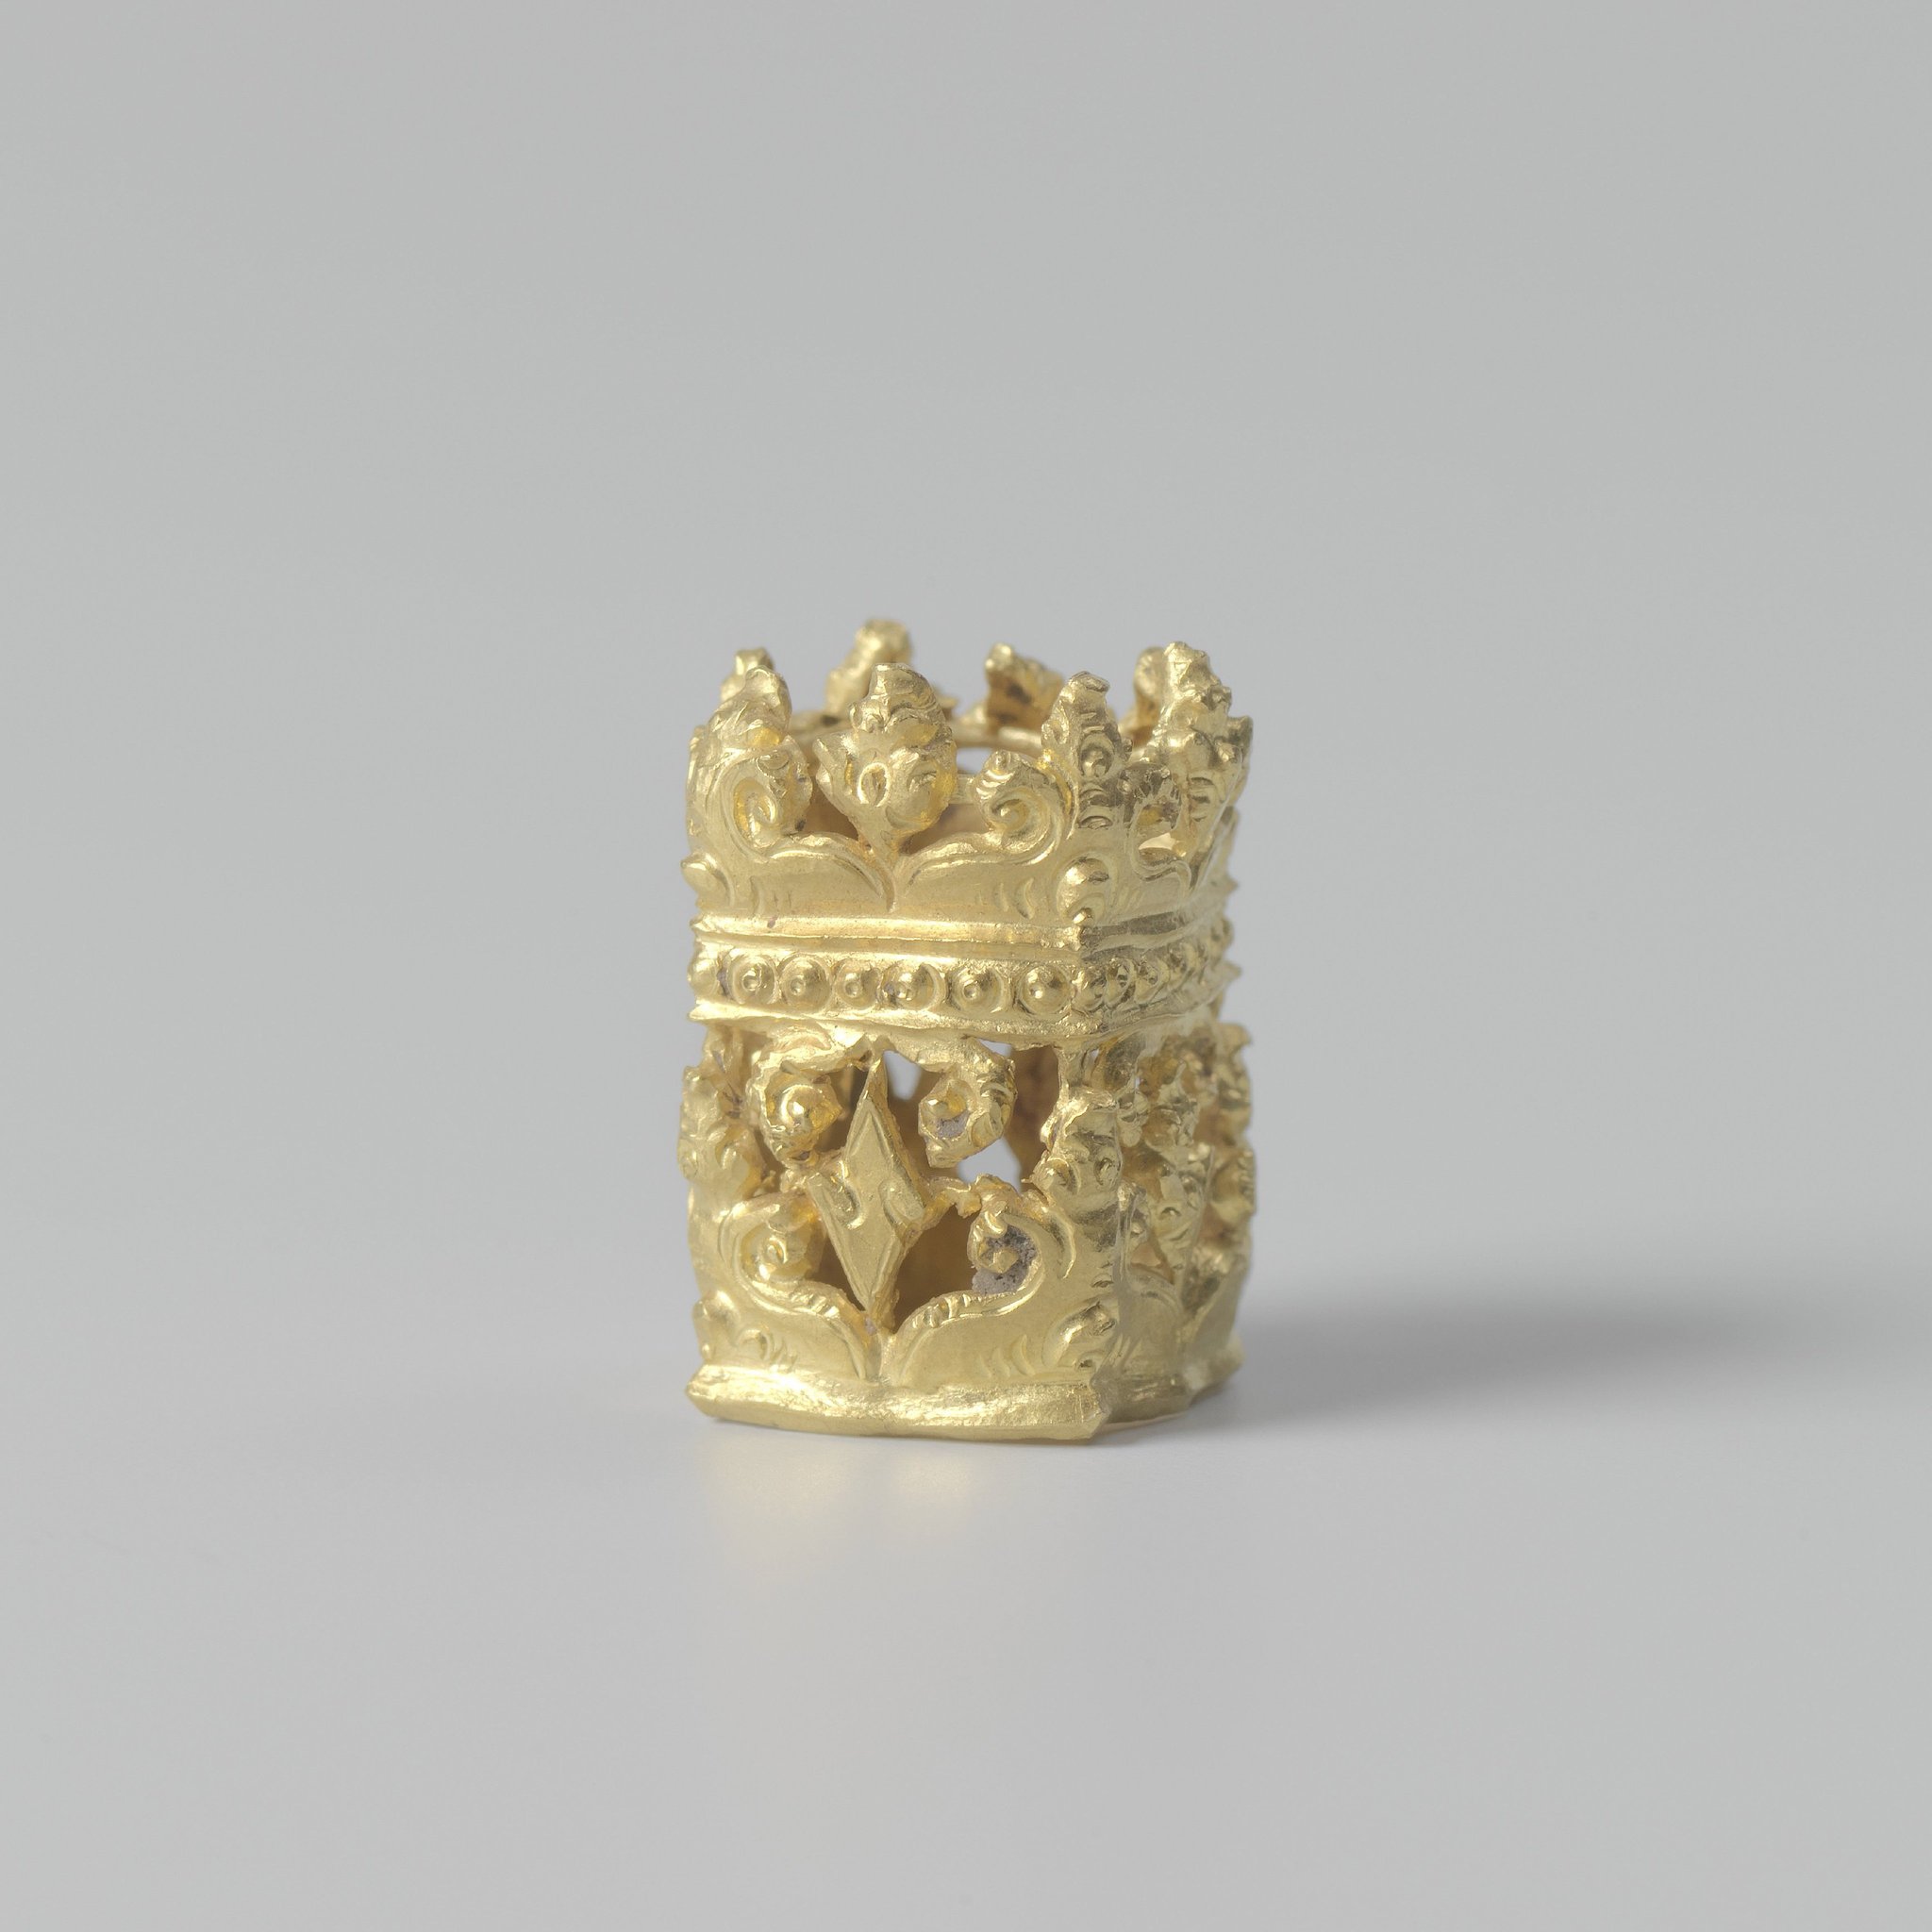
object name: tube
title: Four-Sided Ornament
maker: Anonymous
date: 1300-1400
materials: gold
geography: indonesia